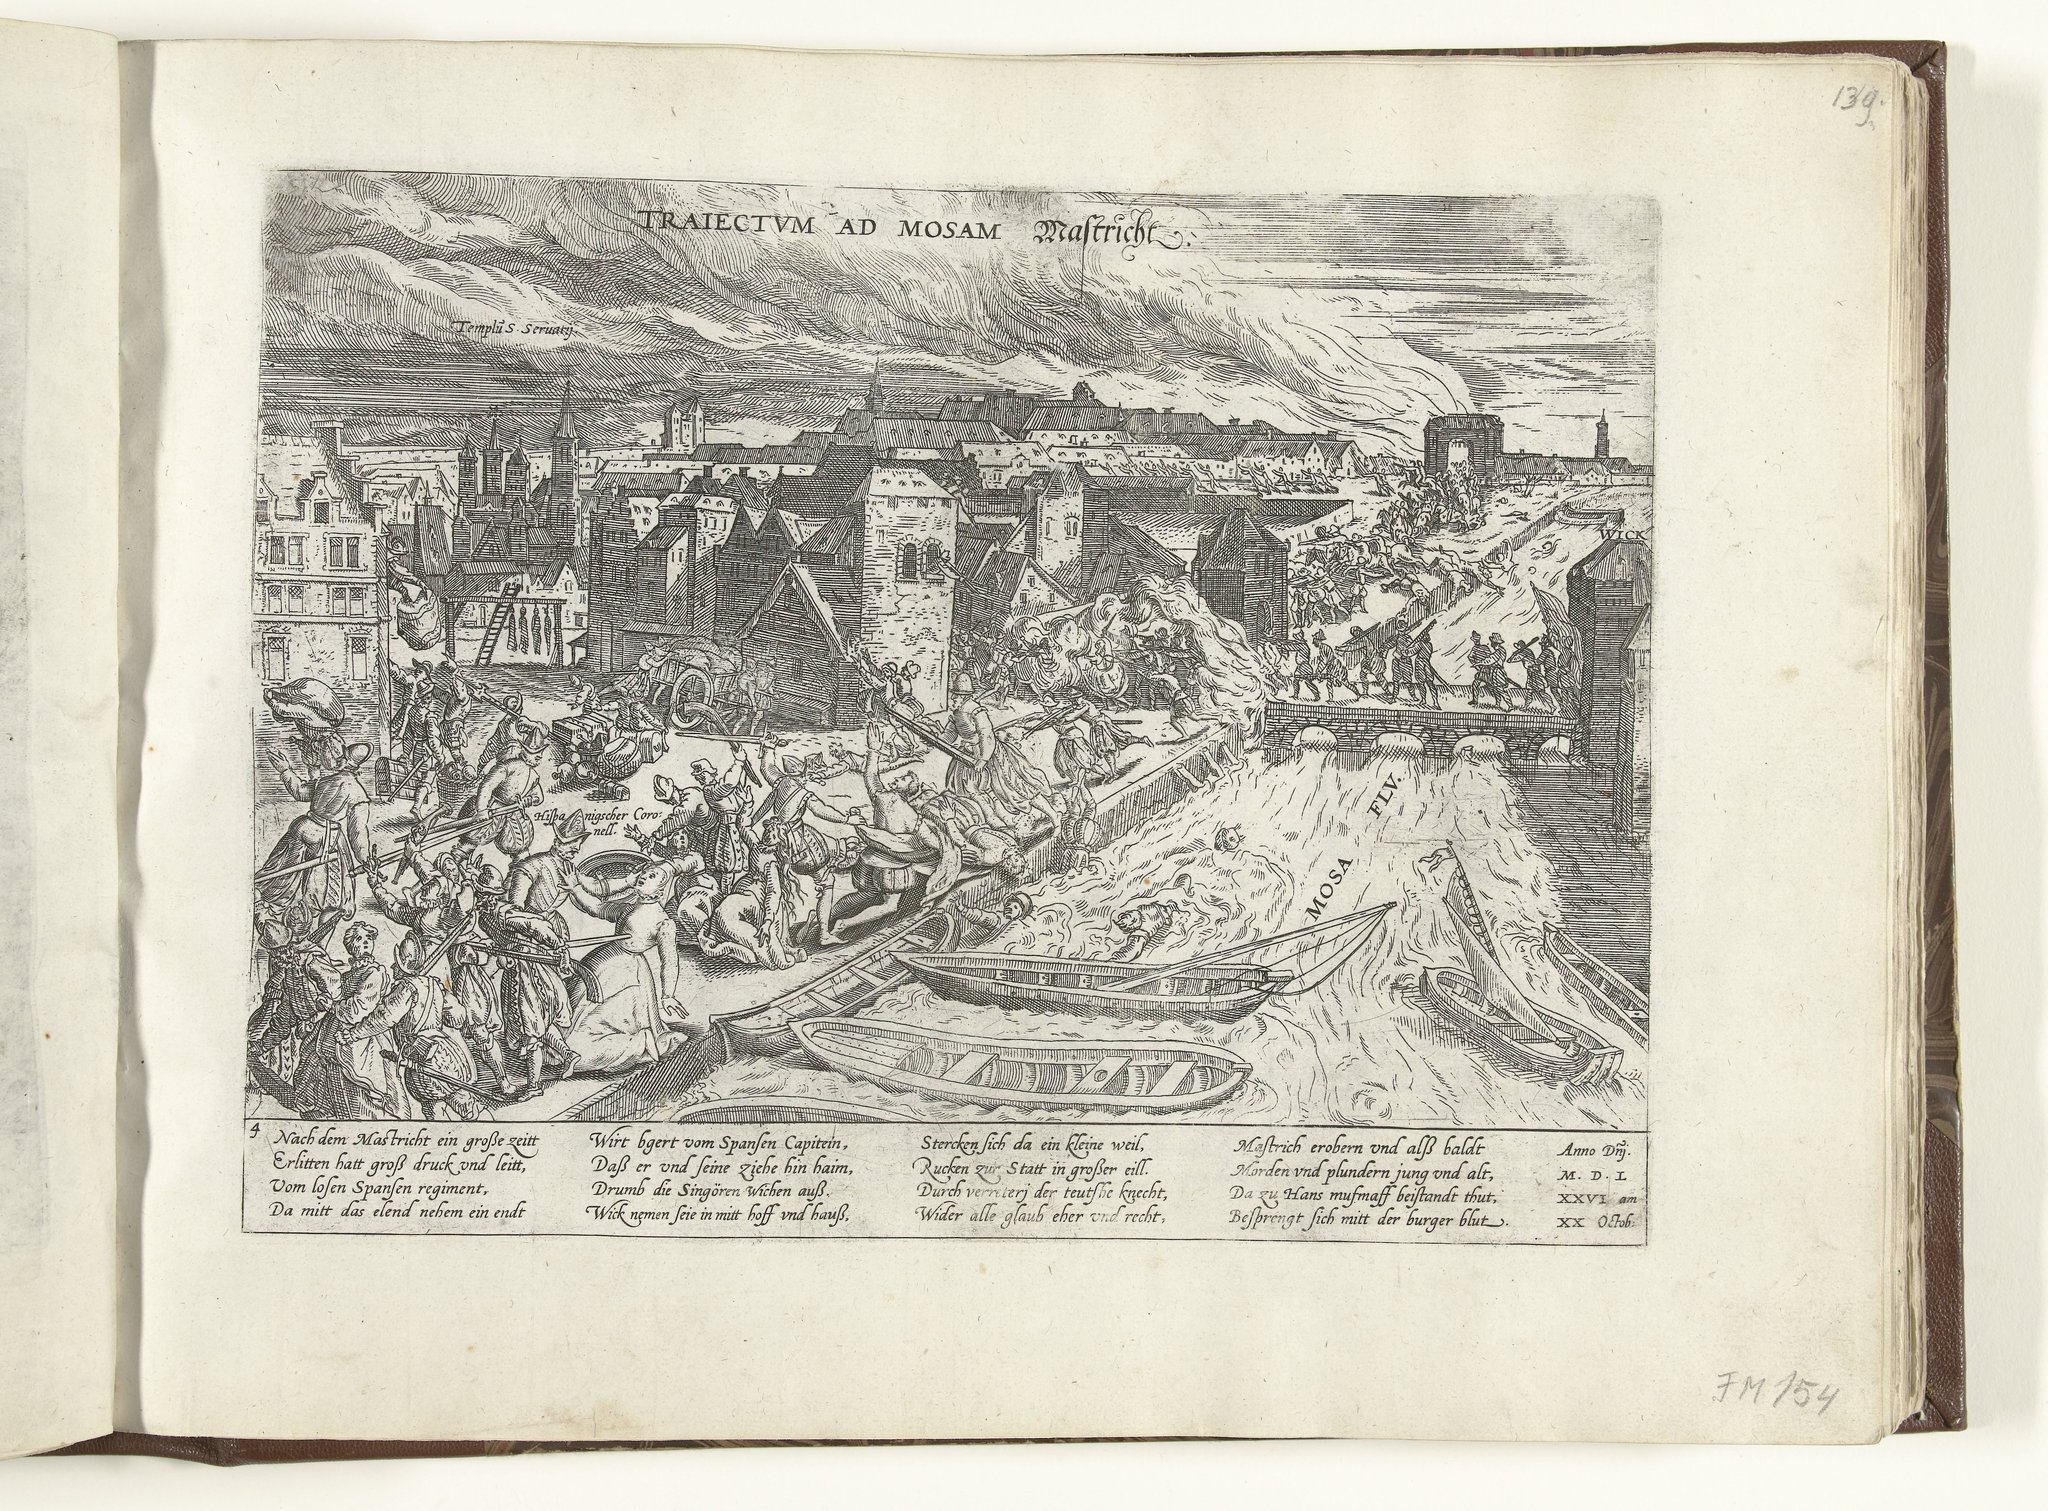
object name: album leaf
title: Moord te Maastricht, 1576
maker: frans hogenberg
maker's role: print maker, publisher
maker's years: 1538-1590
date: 1576-1578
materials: paper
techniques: etching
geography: cologne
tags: massacre ~ war, maastricht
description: Moord en plundering door Spaanse soldaten te Maastricht, 20 oktober 1576. Langs de oever van de Maas doden Spaanse soldaten inwoners van de stad, in de rookwolken van brandende gebouwen. Met onderschrift van 16 regels in het Duits. Genummerd: 4.